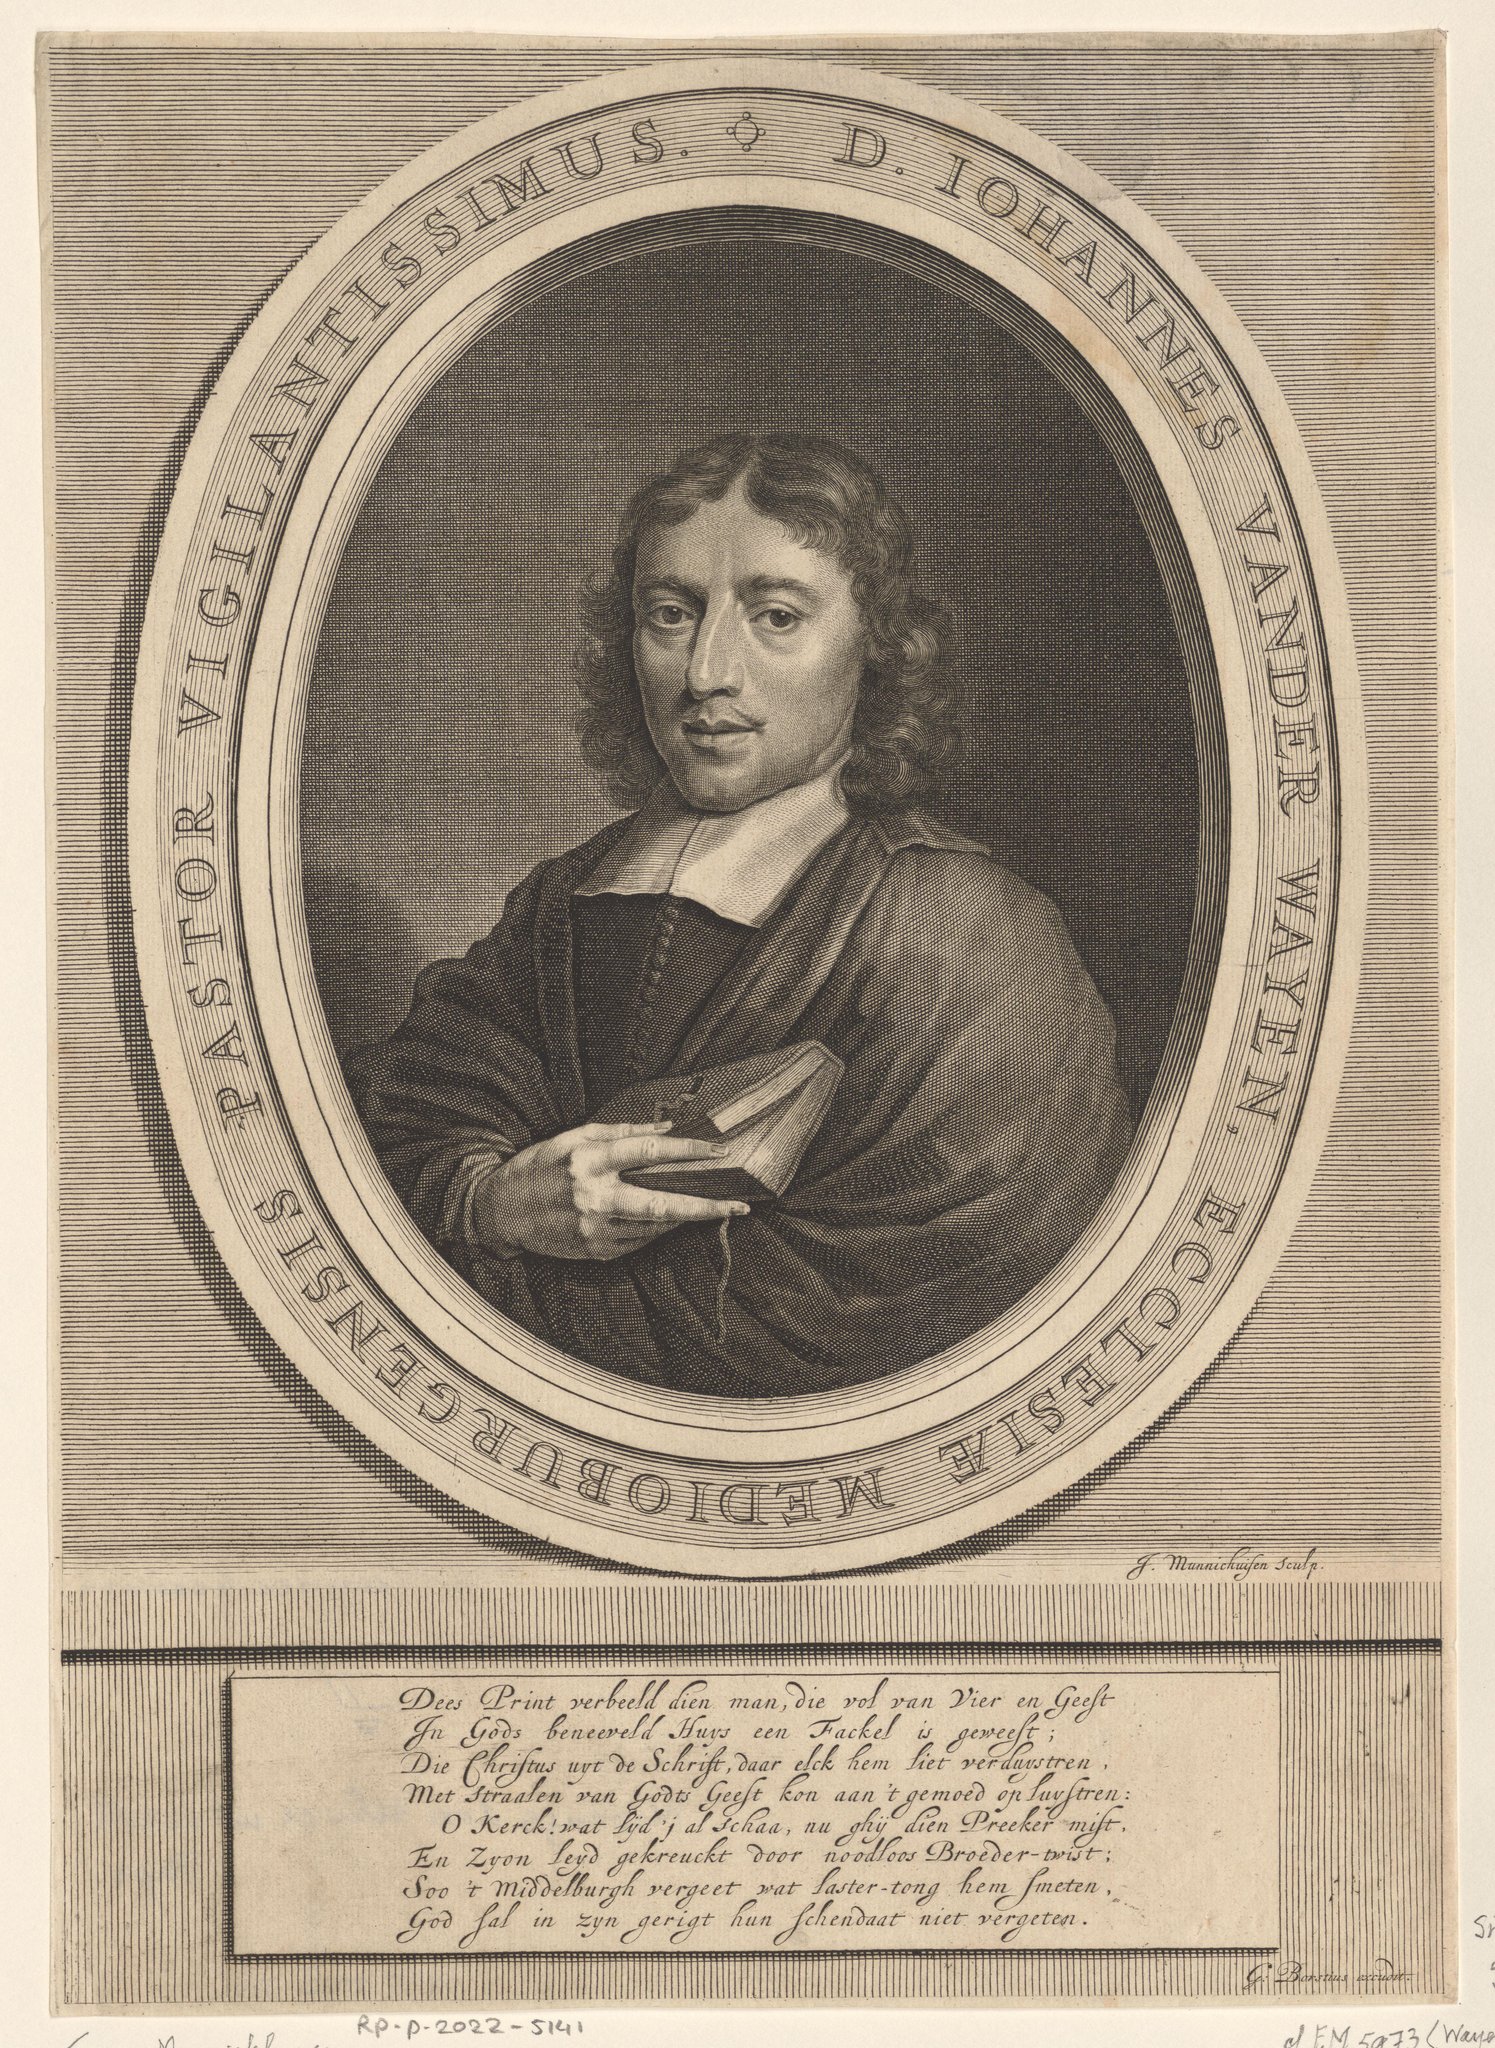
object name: print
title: Portret van Johannes van der Waeyen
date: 1701-1707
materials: paper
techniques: engraving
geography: amsterdam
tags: amsterdam, functionaries and dignitaries (with name) ~ protestant churches, theologian, historical persons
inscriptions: collector's mark: Lugt 2228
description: Onder het portret een achtregelig vers in het Nederlands.